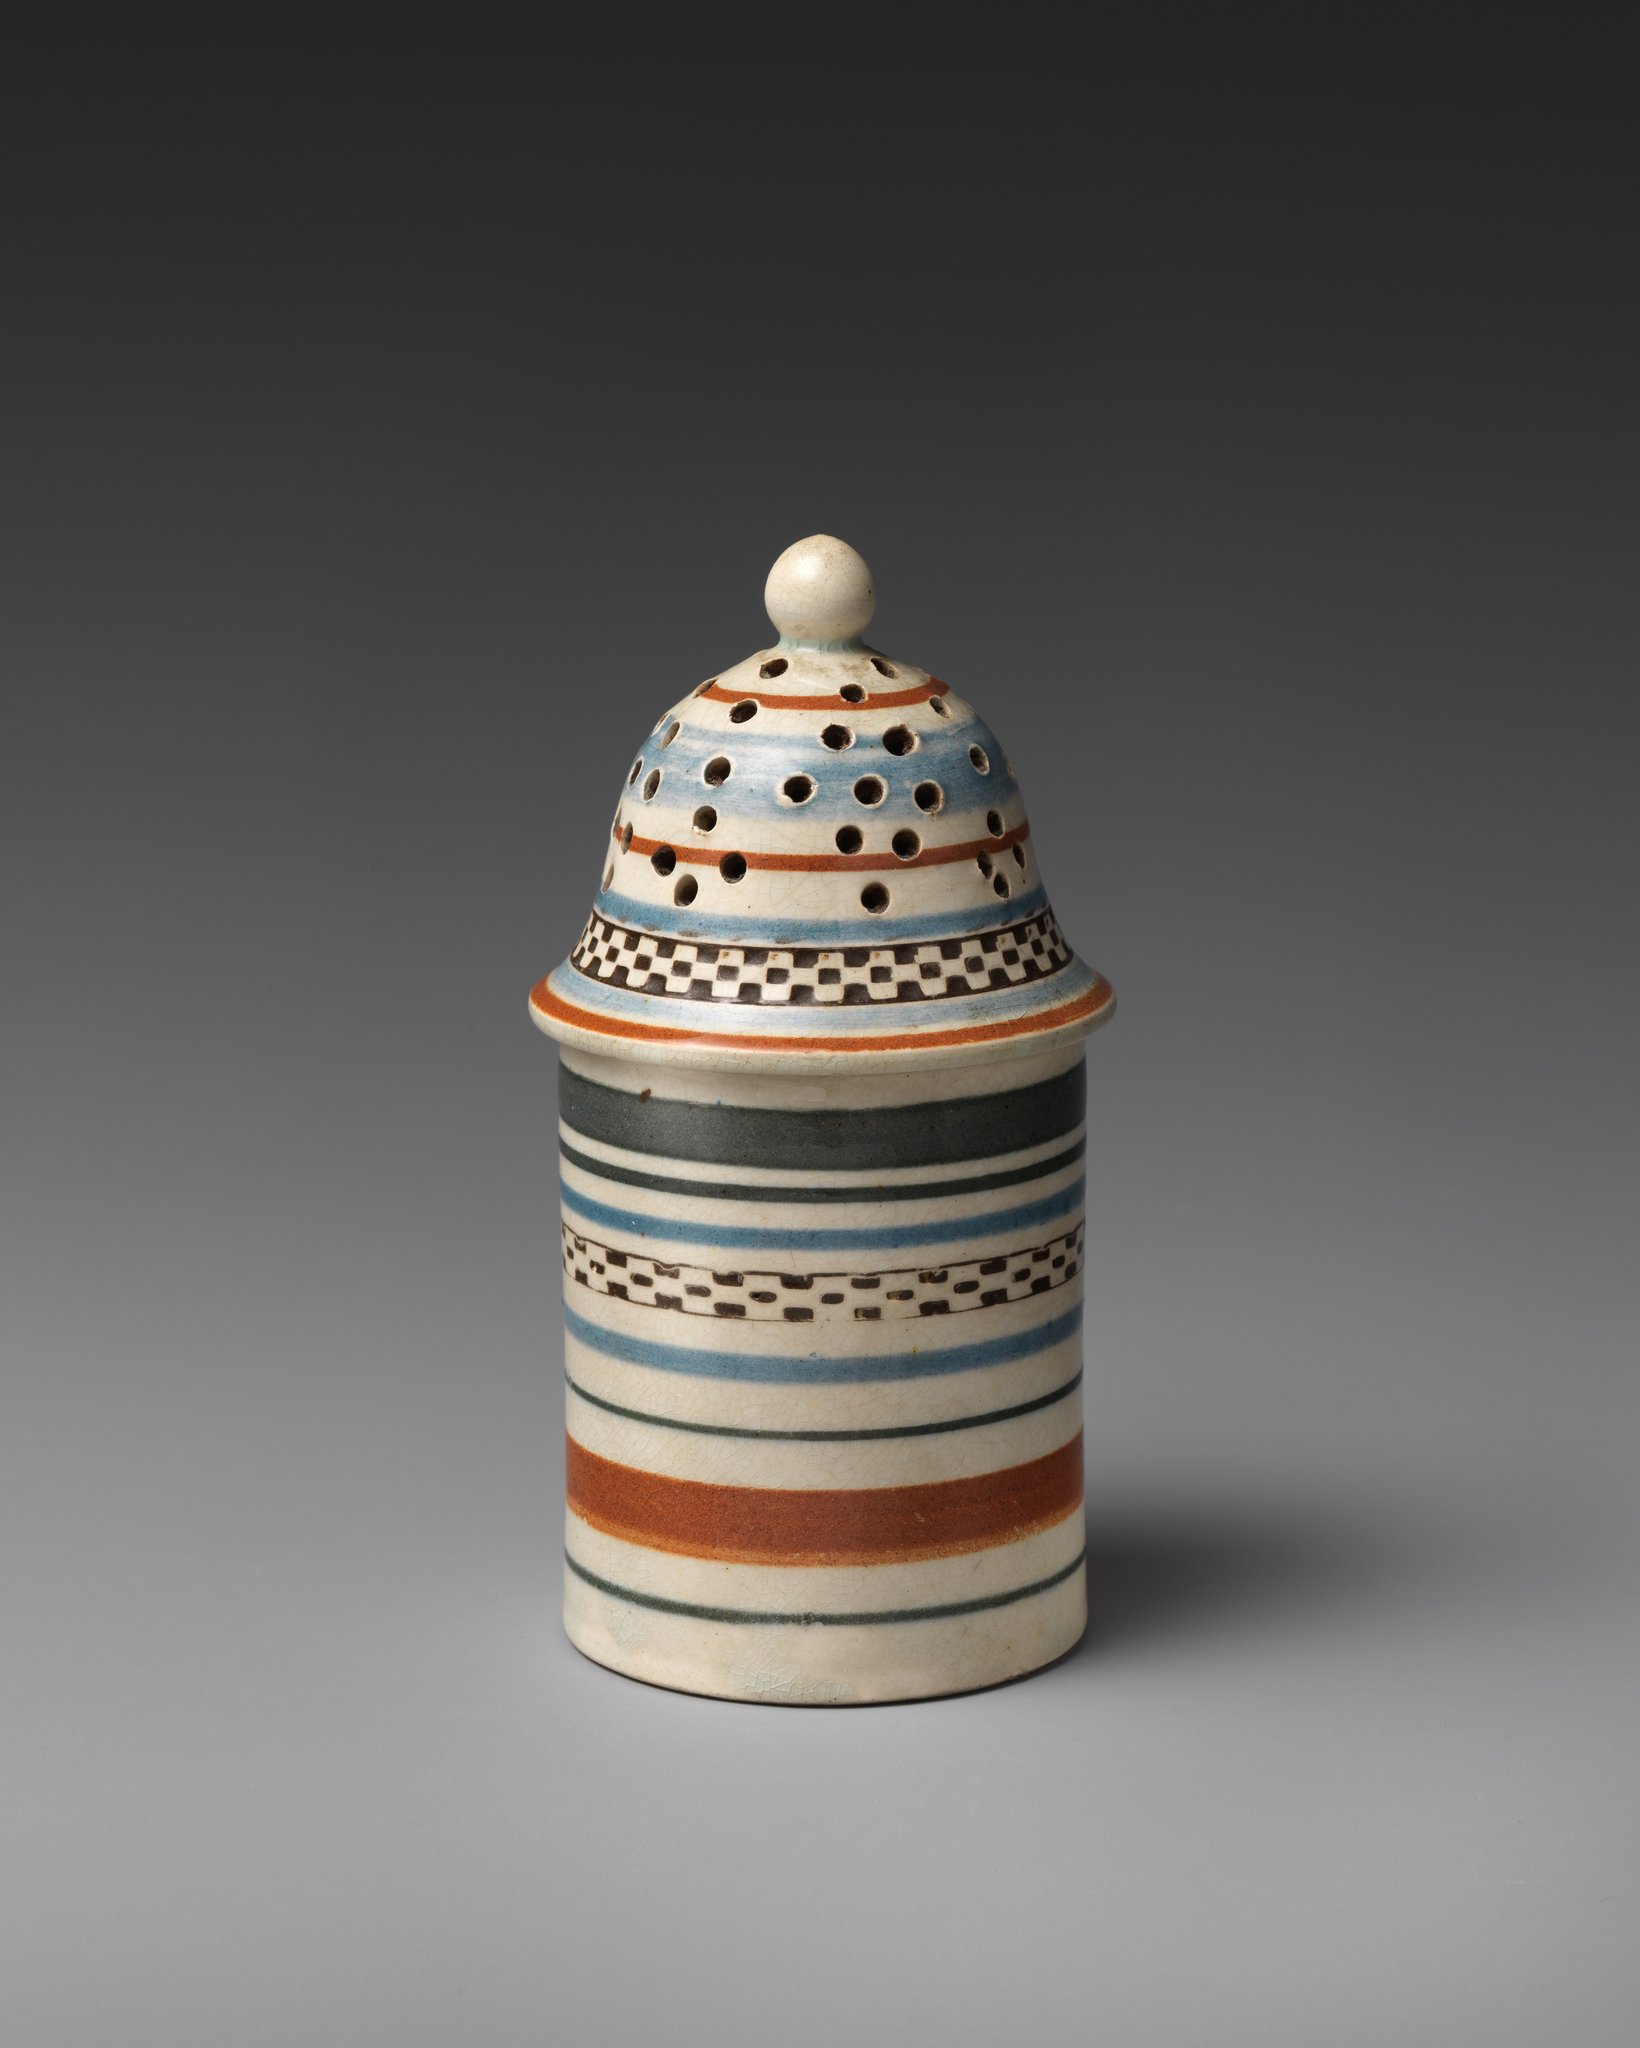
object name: pepper pot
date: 1800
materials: pottery